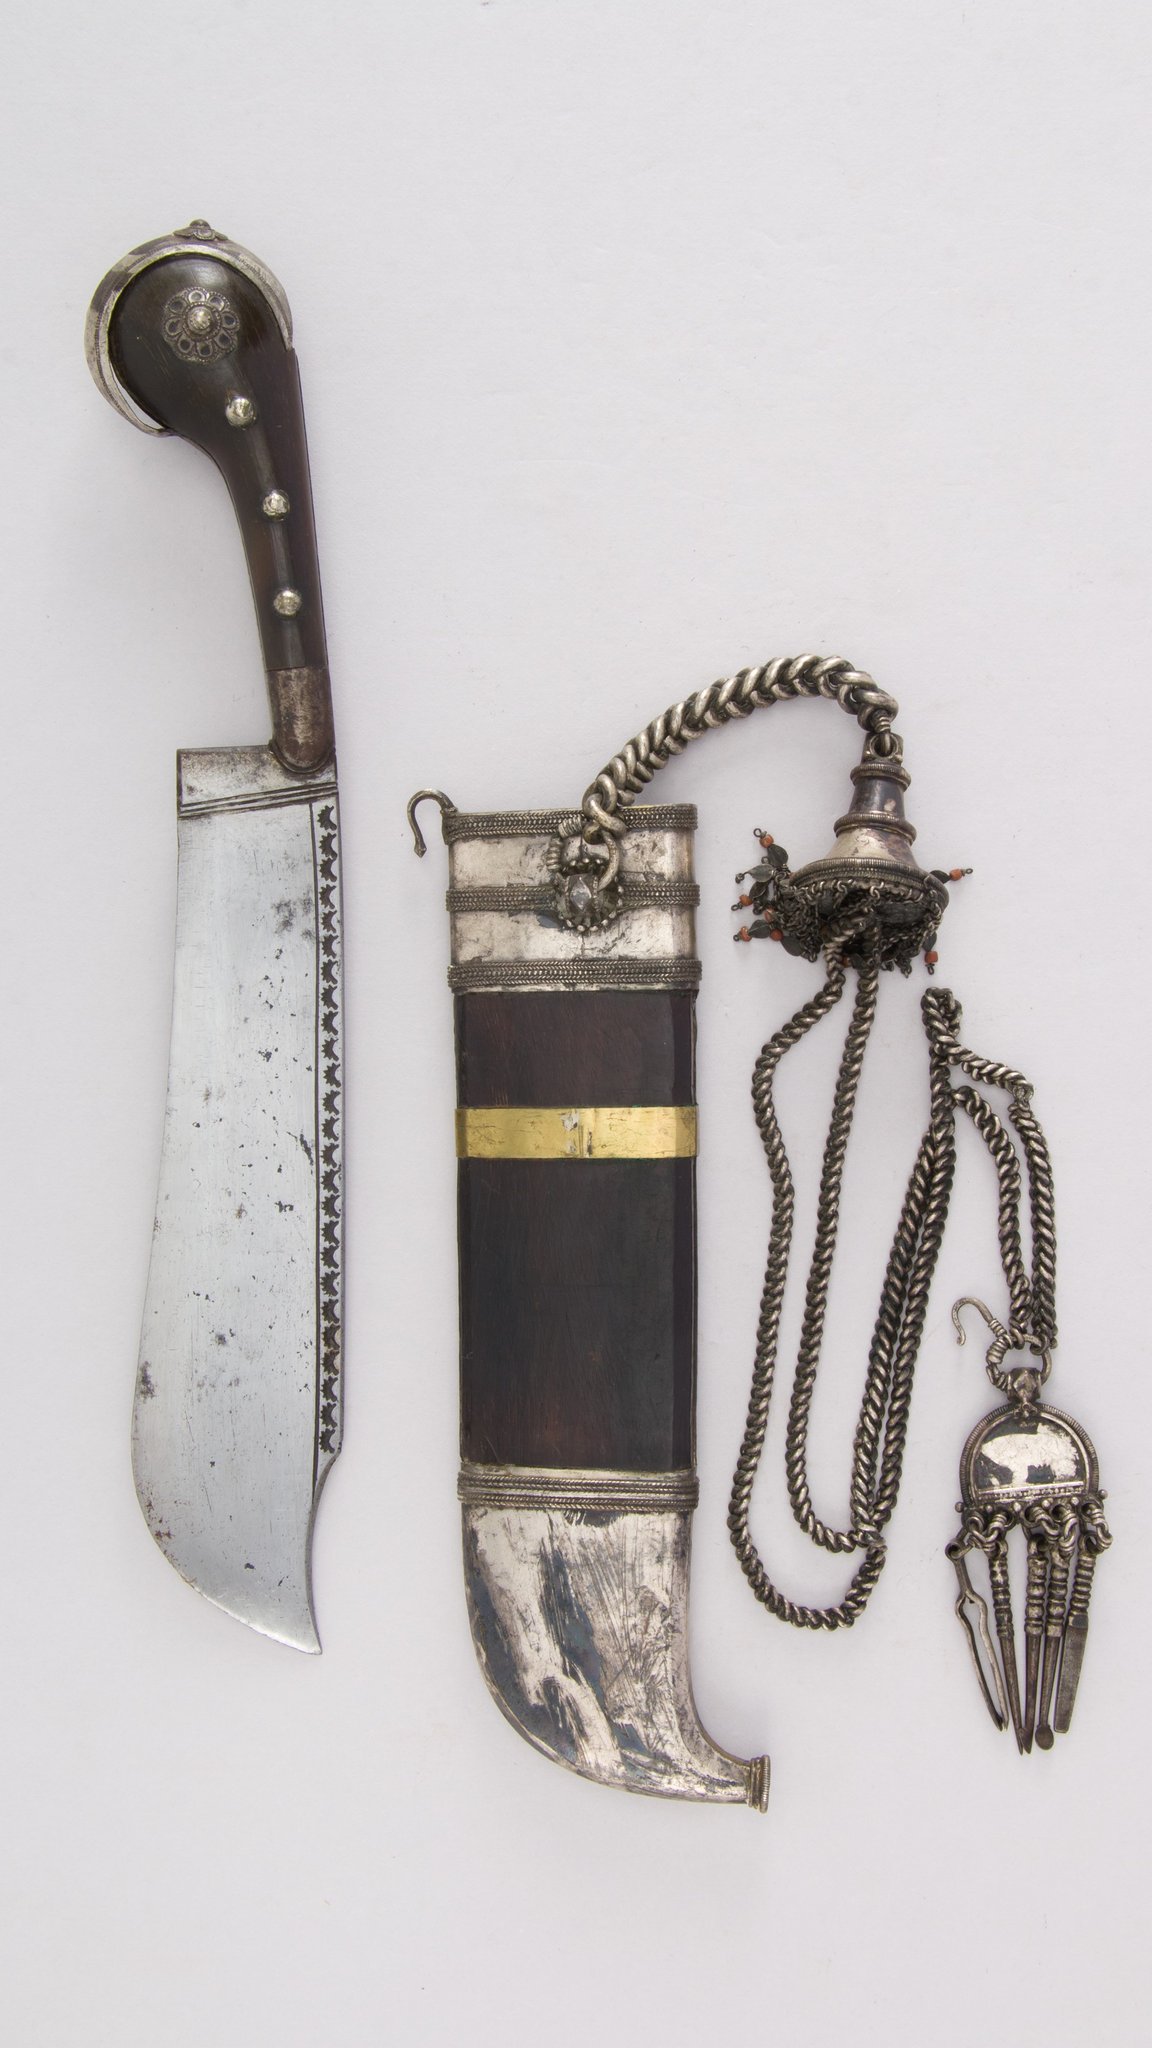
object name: knife pichangatti with sheath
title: Knife (Pichangatti) and Sheath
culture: indian, kodagu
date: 1701-1900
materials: brass, coral, horn, silver, steel, wood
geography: india